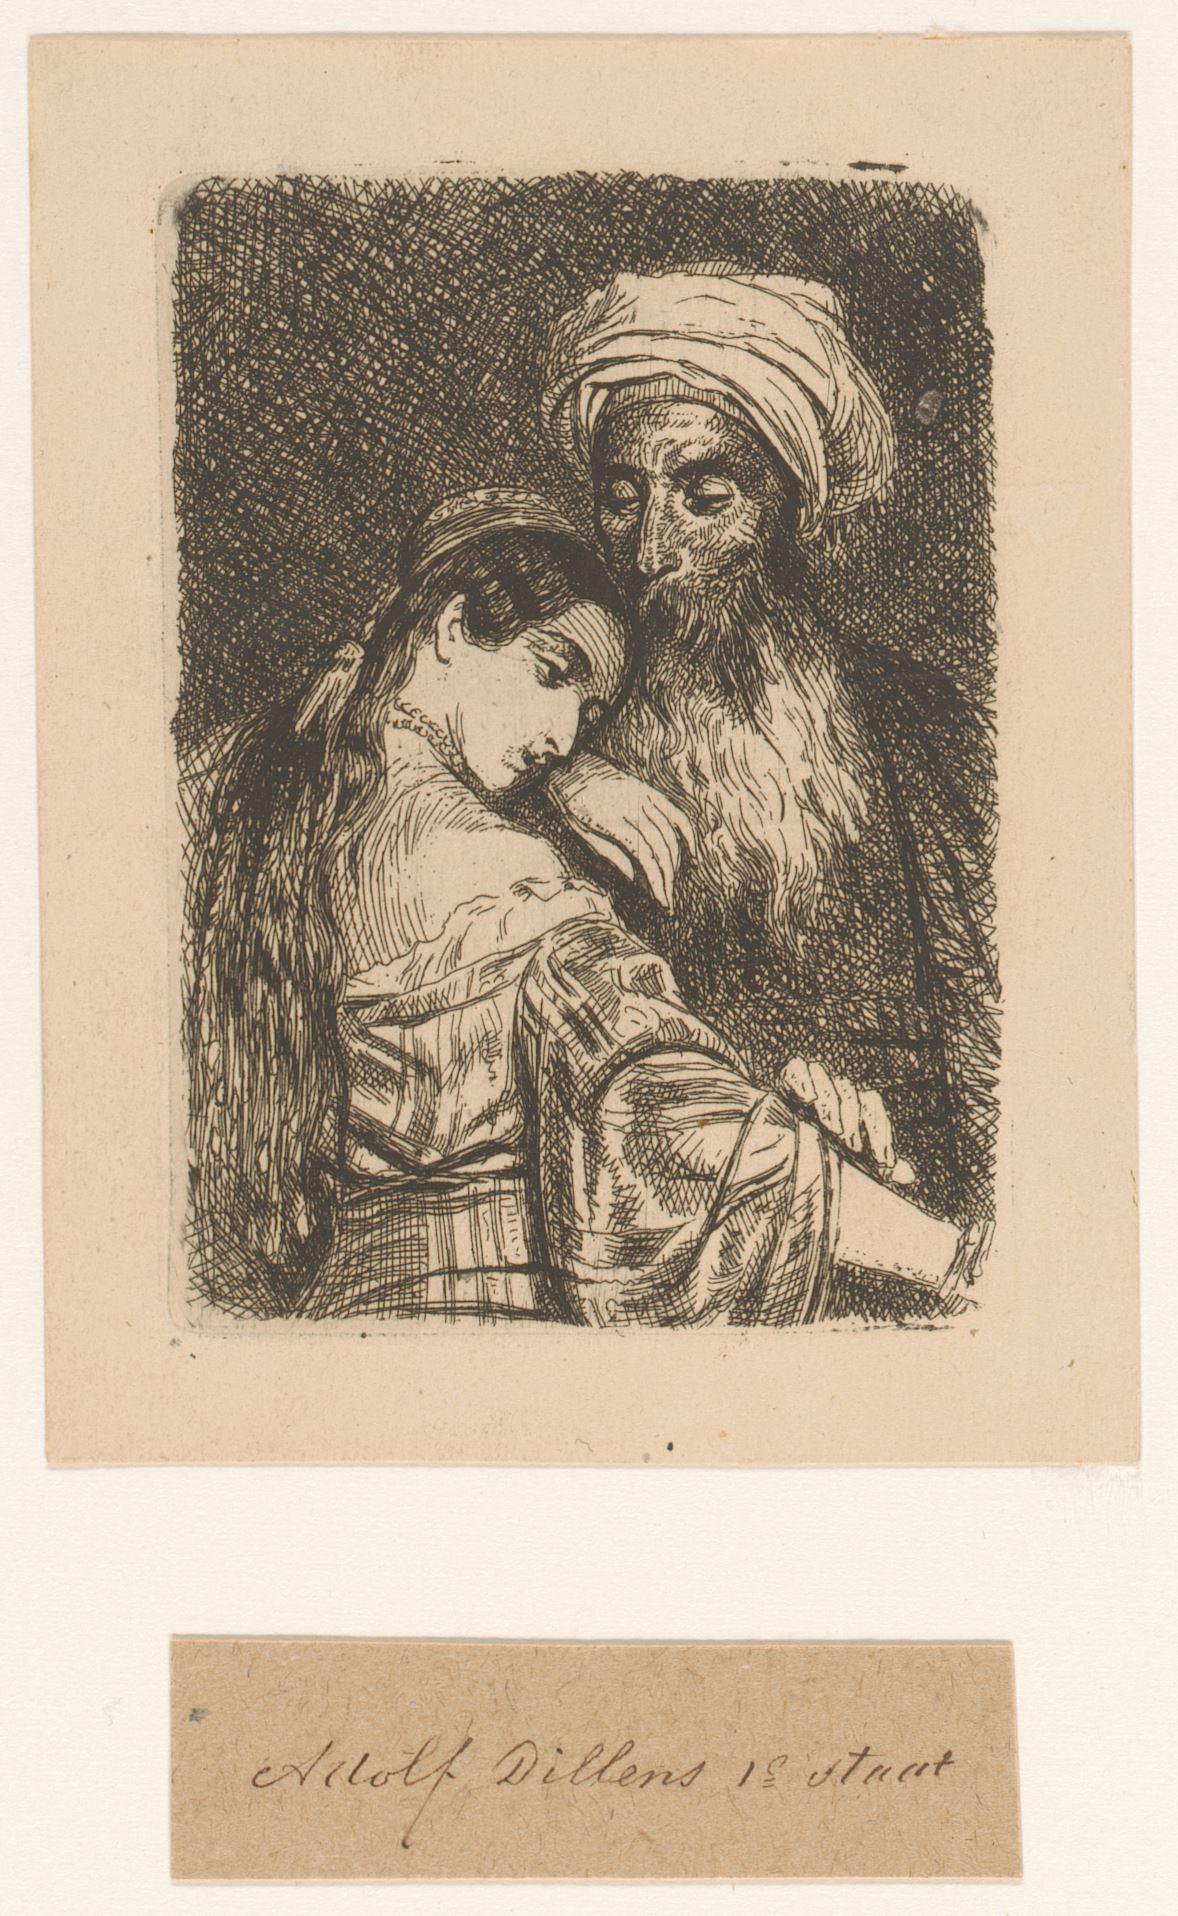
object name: print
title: Vrouw leunend op de schouder van een man met tulband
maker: adolphe alexandre dillens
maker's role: draughtsman, painter, print maker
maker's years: 1821-1877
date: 1831-1877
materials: paper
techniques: etching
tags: adolescent, young woman, maiden, head-gear, adult man, bracelet, wristlet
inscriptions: collector's mark: Lugt 2227